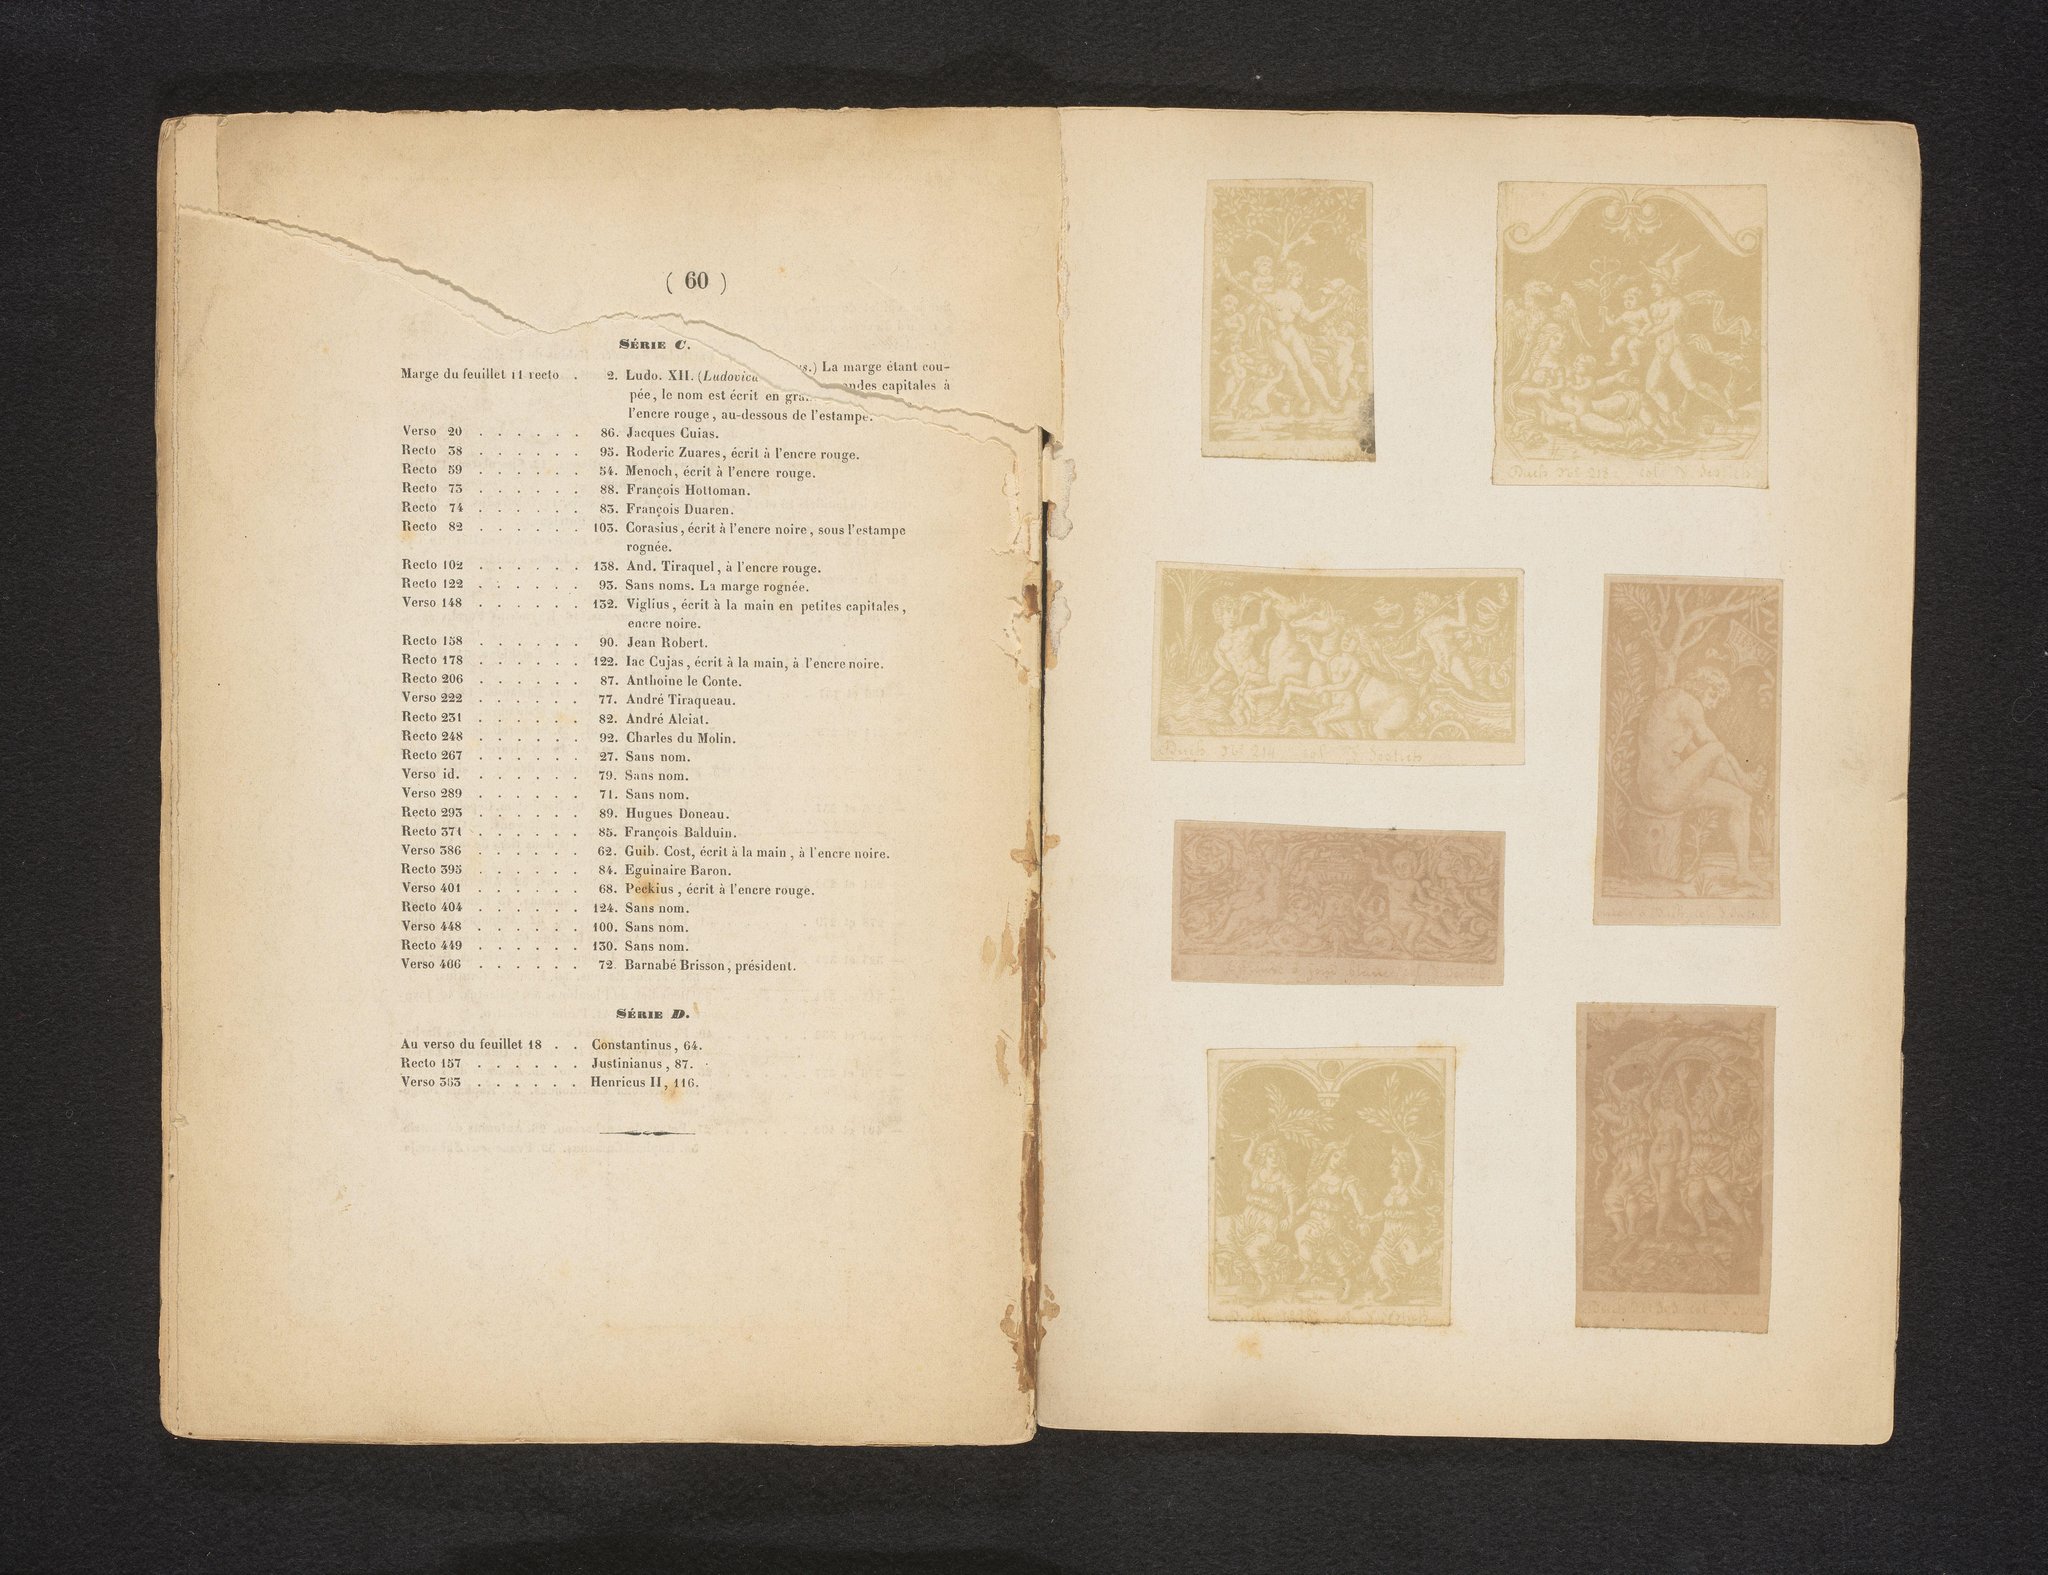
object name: page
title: Fotoreproductie van een prent van de triomf van Neptunus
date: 1852-1857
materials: photographic support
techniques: salted paper print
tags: triumph of neptune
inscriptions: inscription: ‘Duch. No. 214. col. V. Sestich’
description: Foto op blad met zeven foto's tegenover pagina 60.